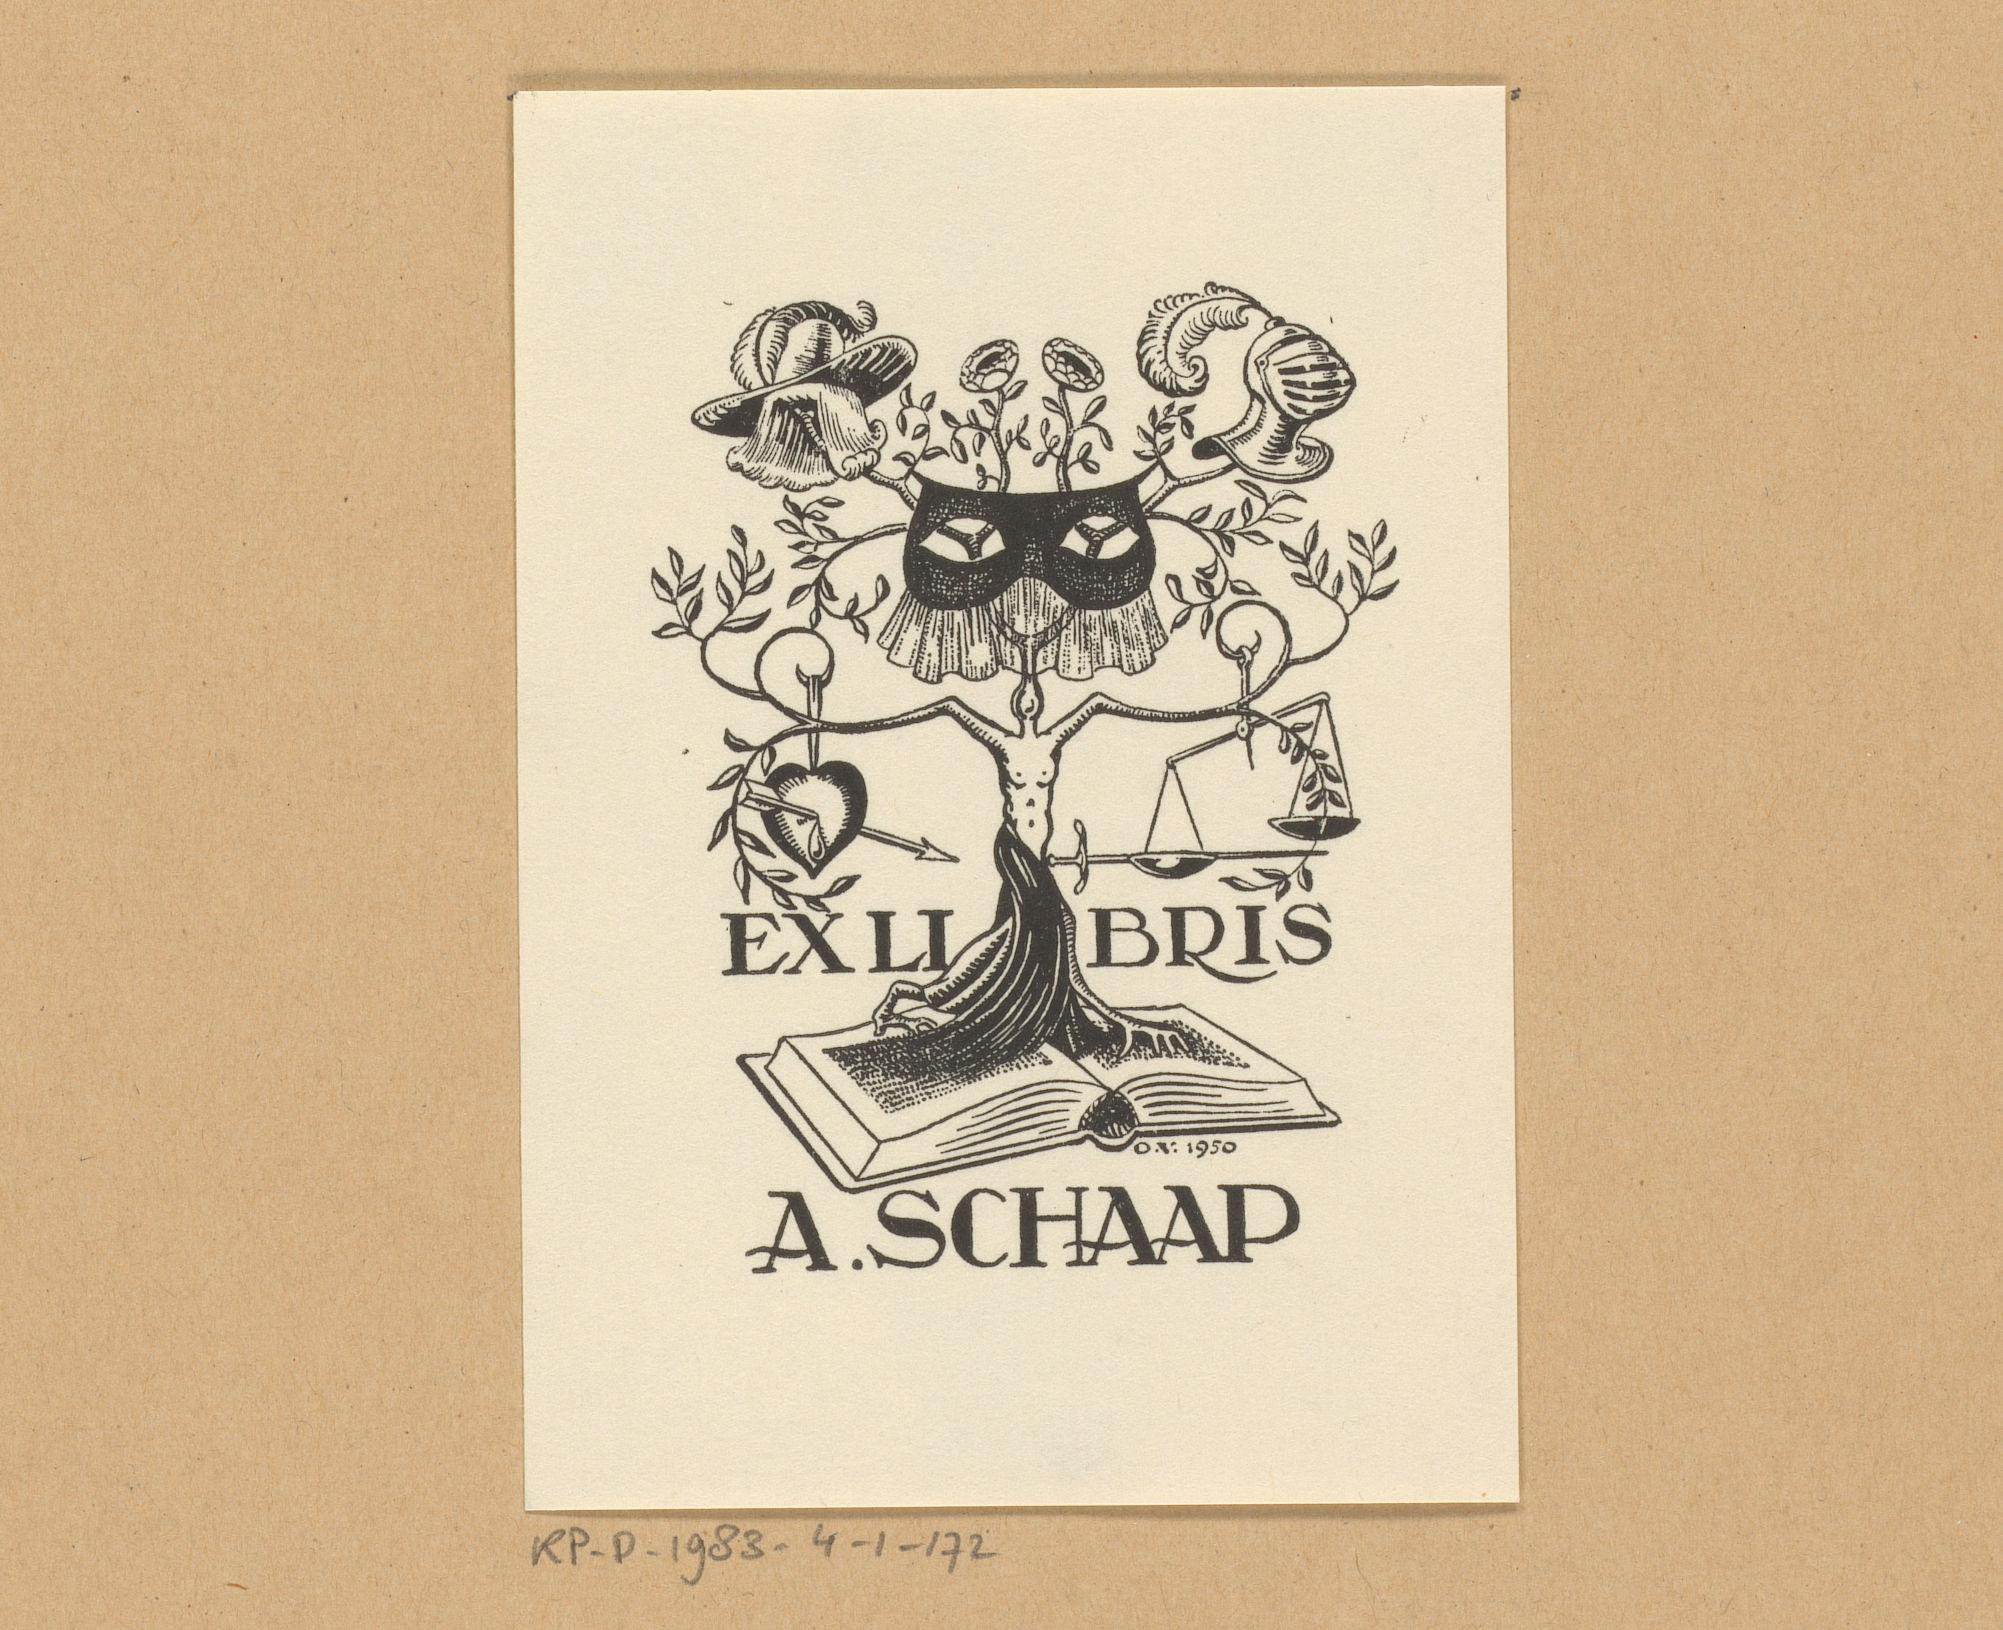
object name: bookplate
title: Ex libris van A. Schaap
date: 1950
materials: paper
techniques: printing block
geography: netherlands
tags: mask, trees, book, law and jurisprudence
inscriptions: inscription: ‘cliché naar pentekening (...) slotte "het mysterie"’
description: Eigenaar is Inspecteur der Domeinen. De boom die zich ontwikkelt tot een vrouwfiguur draagt "vruchten" als "de romantiek" (de pruik en hoed), de ridderlijkheid (helm), de liefde (doorboord hart) en het recht (weegschaal en zwaard). Het masker symboliseert "het mysterie".